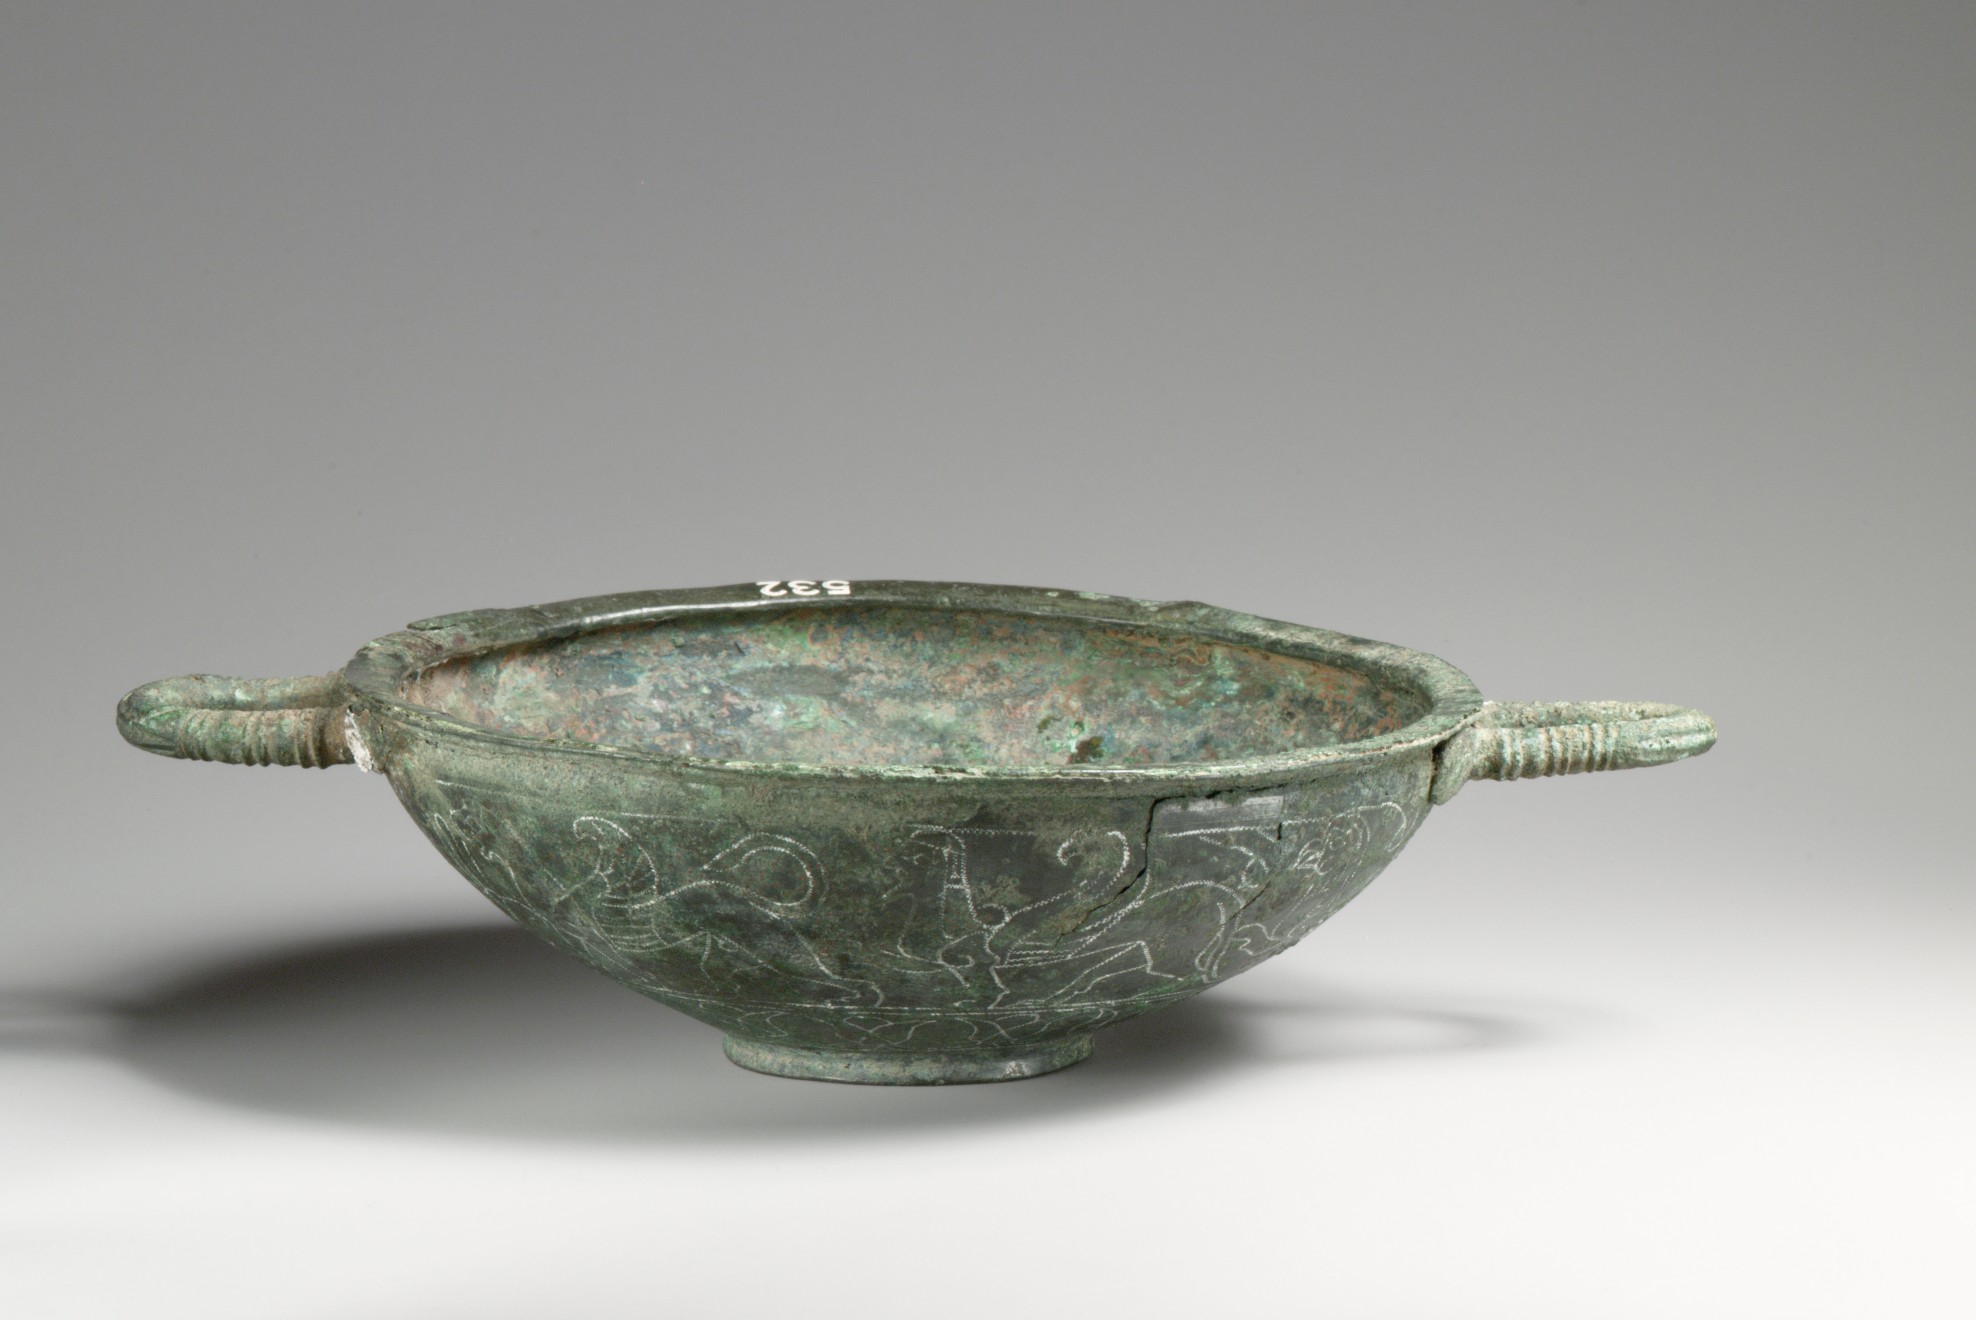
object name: kylix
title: Bronze kylix (cup)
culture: etruscan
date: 700-601 BCE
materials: bronze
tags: sphinx,goats,lions